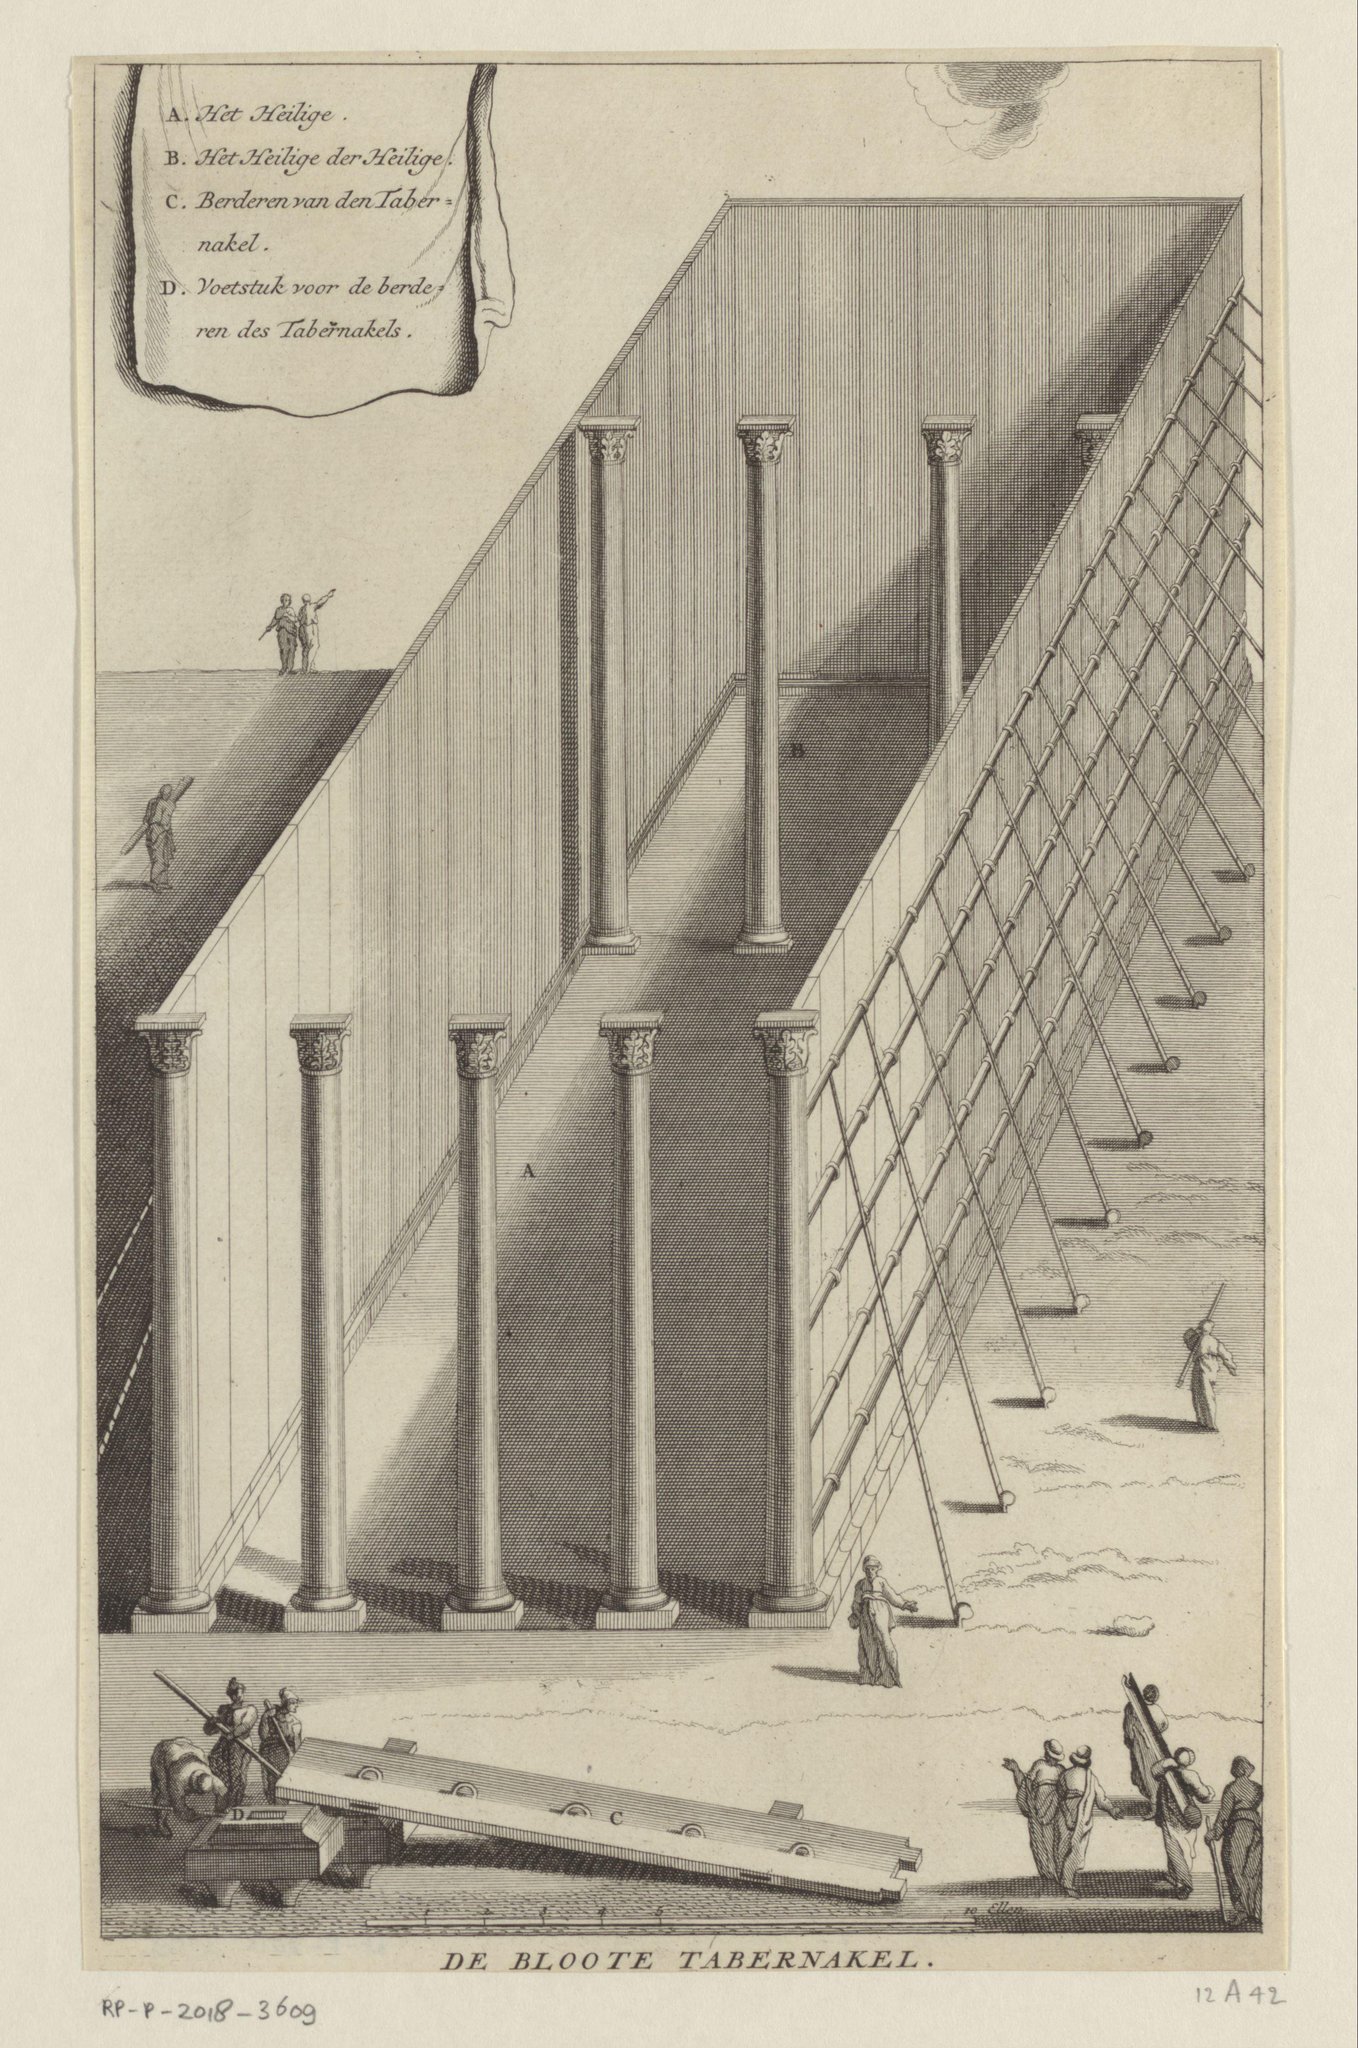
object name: print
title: Bouw van de tabernakel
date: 1725-1731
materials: paper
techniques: engraving, etching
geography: amsterdam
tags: tabernacle, 'mishkan' ~ jewish religion, the making of the tabernacle and its accessories ~ exodus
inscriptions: collector's mark: Lugt 2228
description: Prent gebruikt voor voor: Calmet, Augustin. Het algemeen groot historisch, oordeelkundig, chronologisch, geografisch en letterlyk naam- en woord-boek van den gantschen H. Bybel. Amsterdam: R. en J. Wetstein en W. Smith, Leiden: S. Luchtmans, 1725-1731.